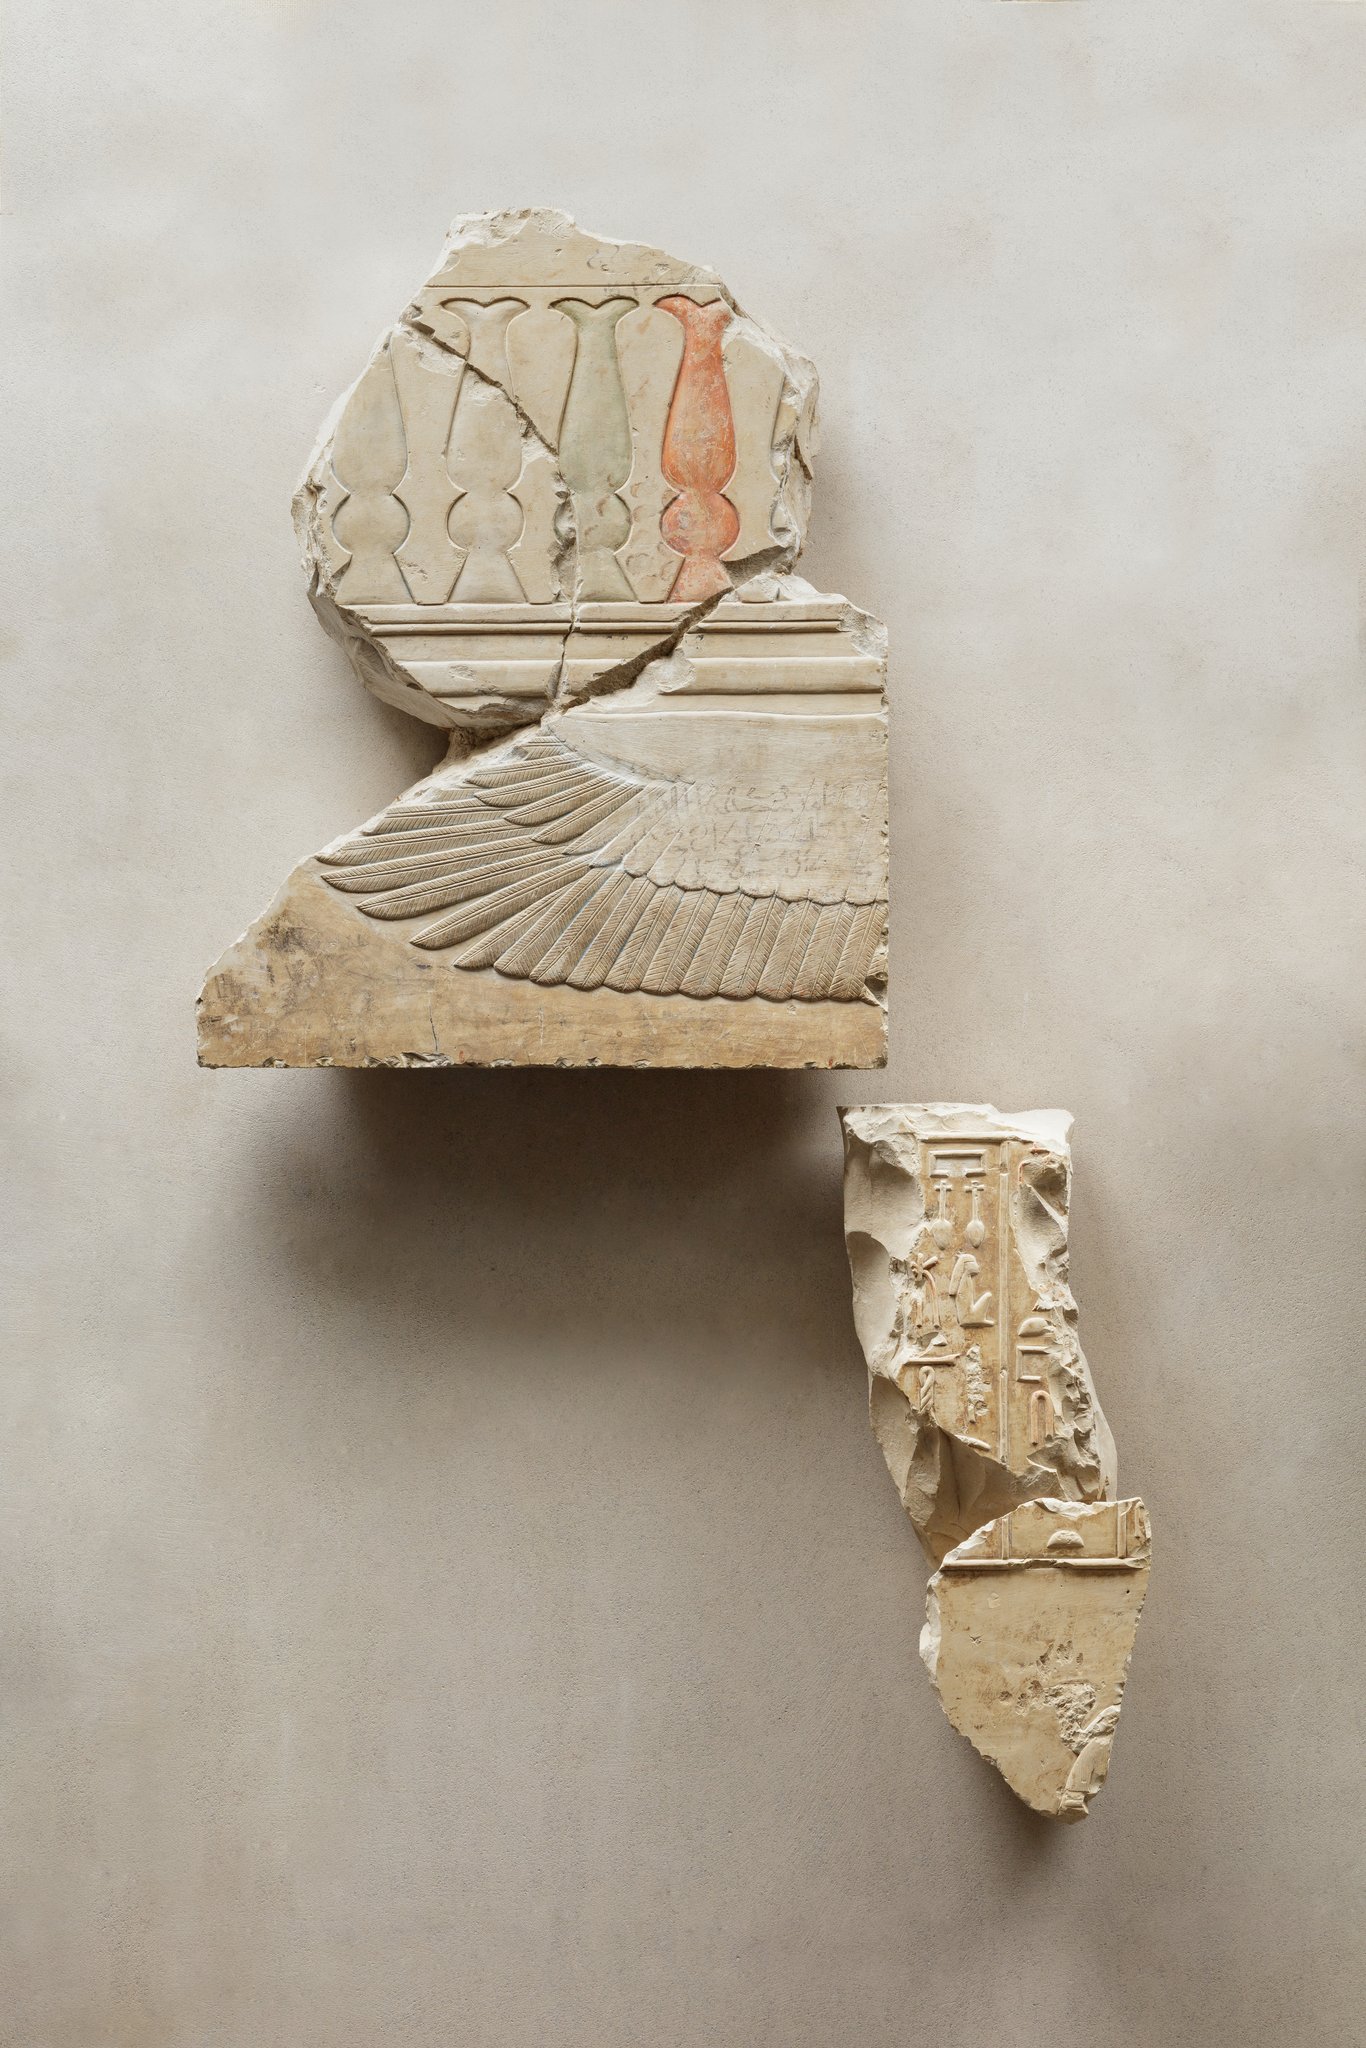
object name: relief, part of scene with king and queen, neferu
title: Relief preserving part of a scene with King Mentuhotep and Queen Neferu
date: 2051-2030 BCE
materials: limestone, paint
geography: egypt